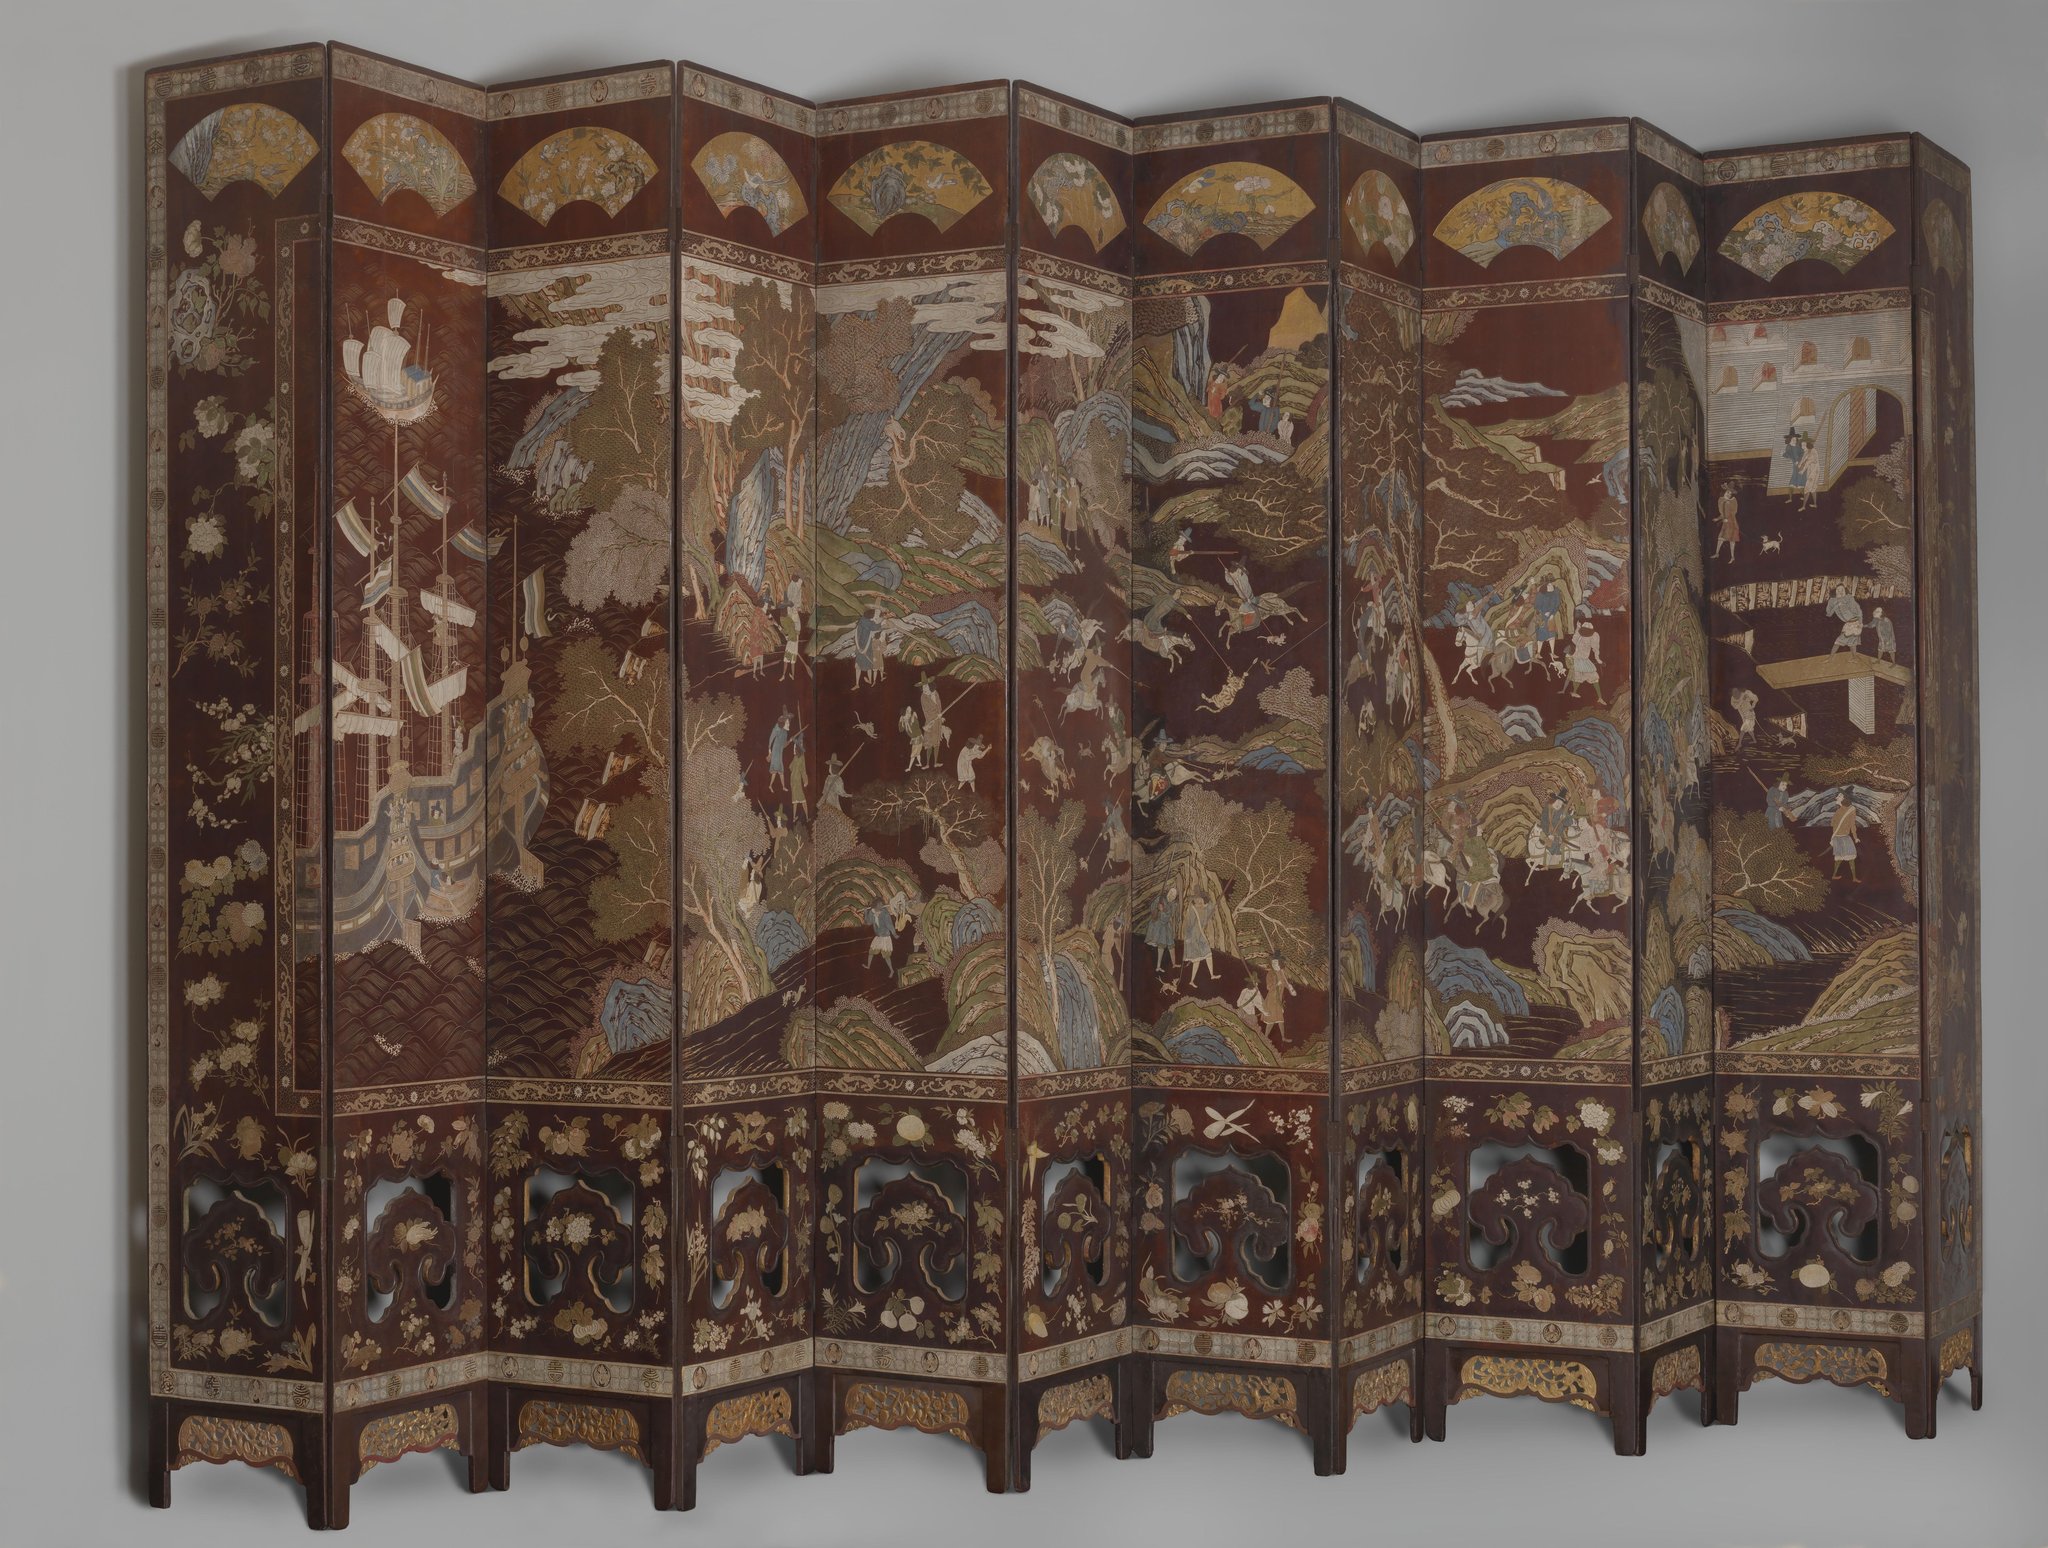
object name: furniture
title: Folding screen of Coromandel lacquer with a scene of Dutch ships, with Dutch people in the hills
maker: Anonymous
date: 1685-1700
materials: bronze, lacquer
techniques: lacquer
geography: south china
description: Depicted on this folding screen is the arrival of Dutch ships, and in the centre a hunting scene with Dutchmen in the leading role. They are depicted somewhat comically. In addition to European firearms, they bear some peculiar hunting gear. Everything suggests that the depiction sprouted from the artisan’s imagination to cater to the Chinese public’s curiosity about the ever so strange Europe.